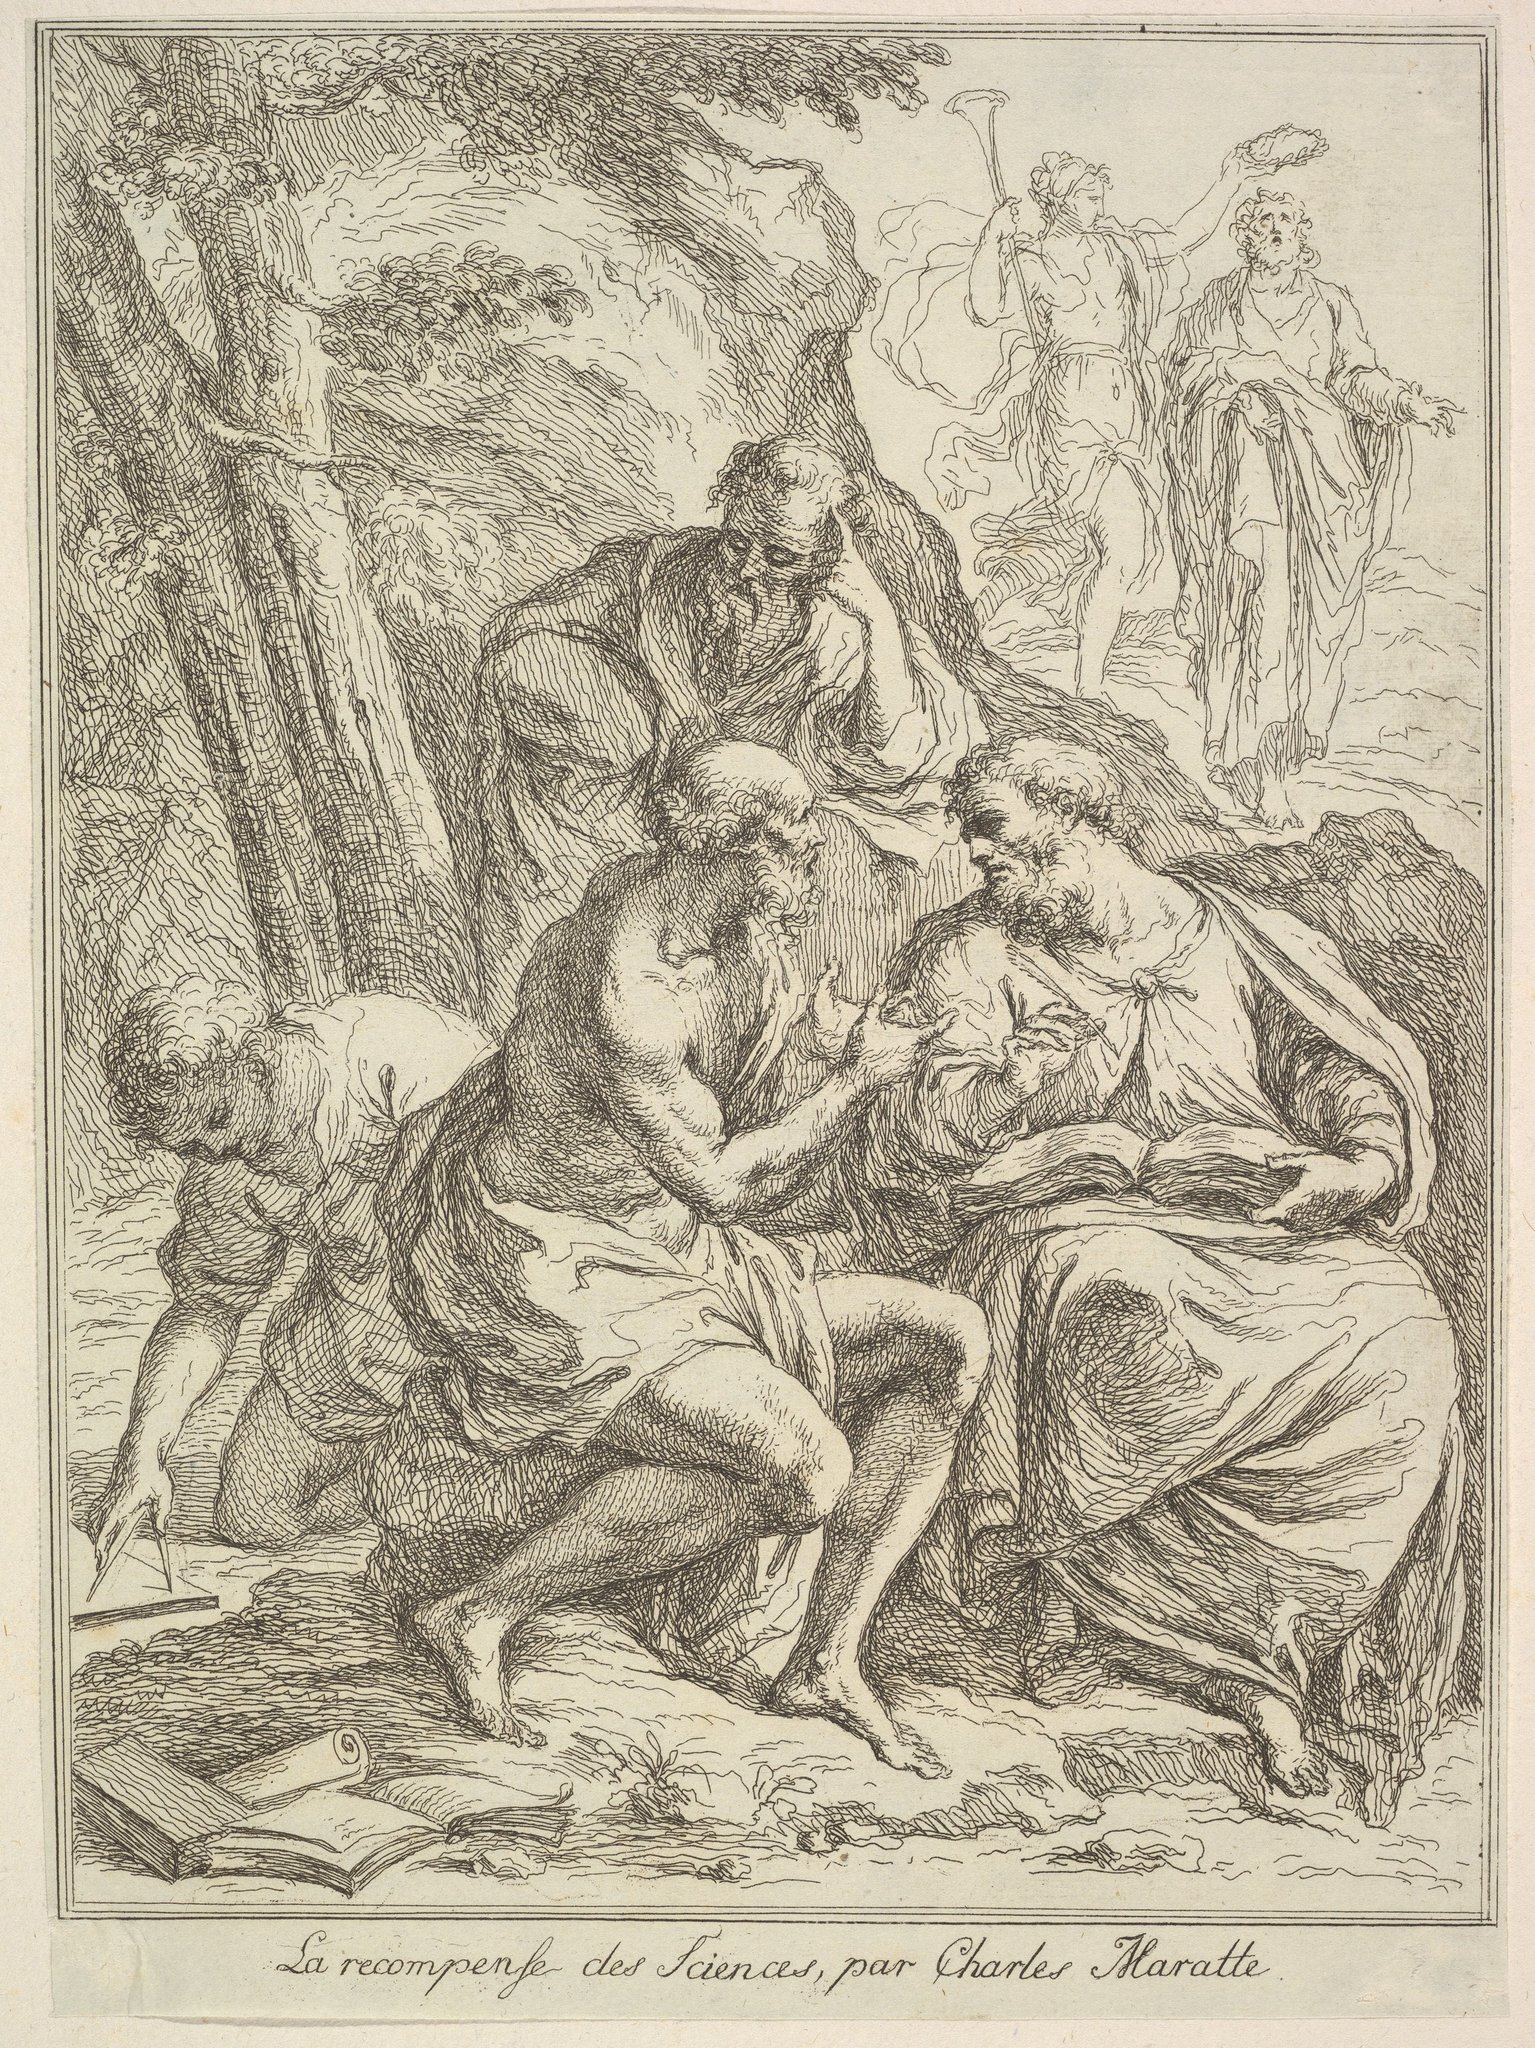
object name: print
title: La recompense des Sciences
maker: carlo maratti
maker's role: artist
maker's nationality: italian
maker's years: 1625-1713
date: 1640-1713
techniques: etching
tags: men,trees